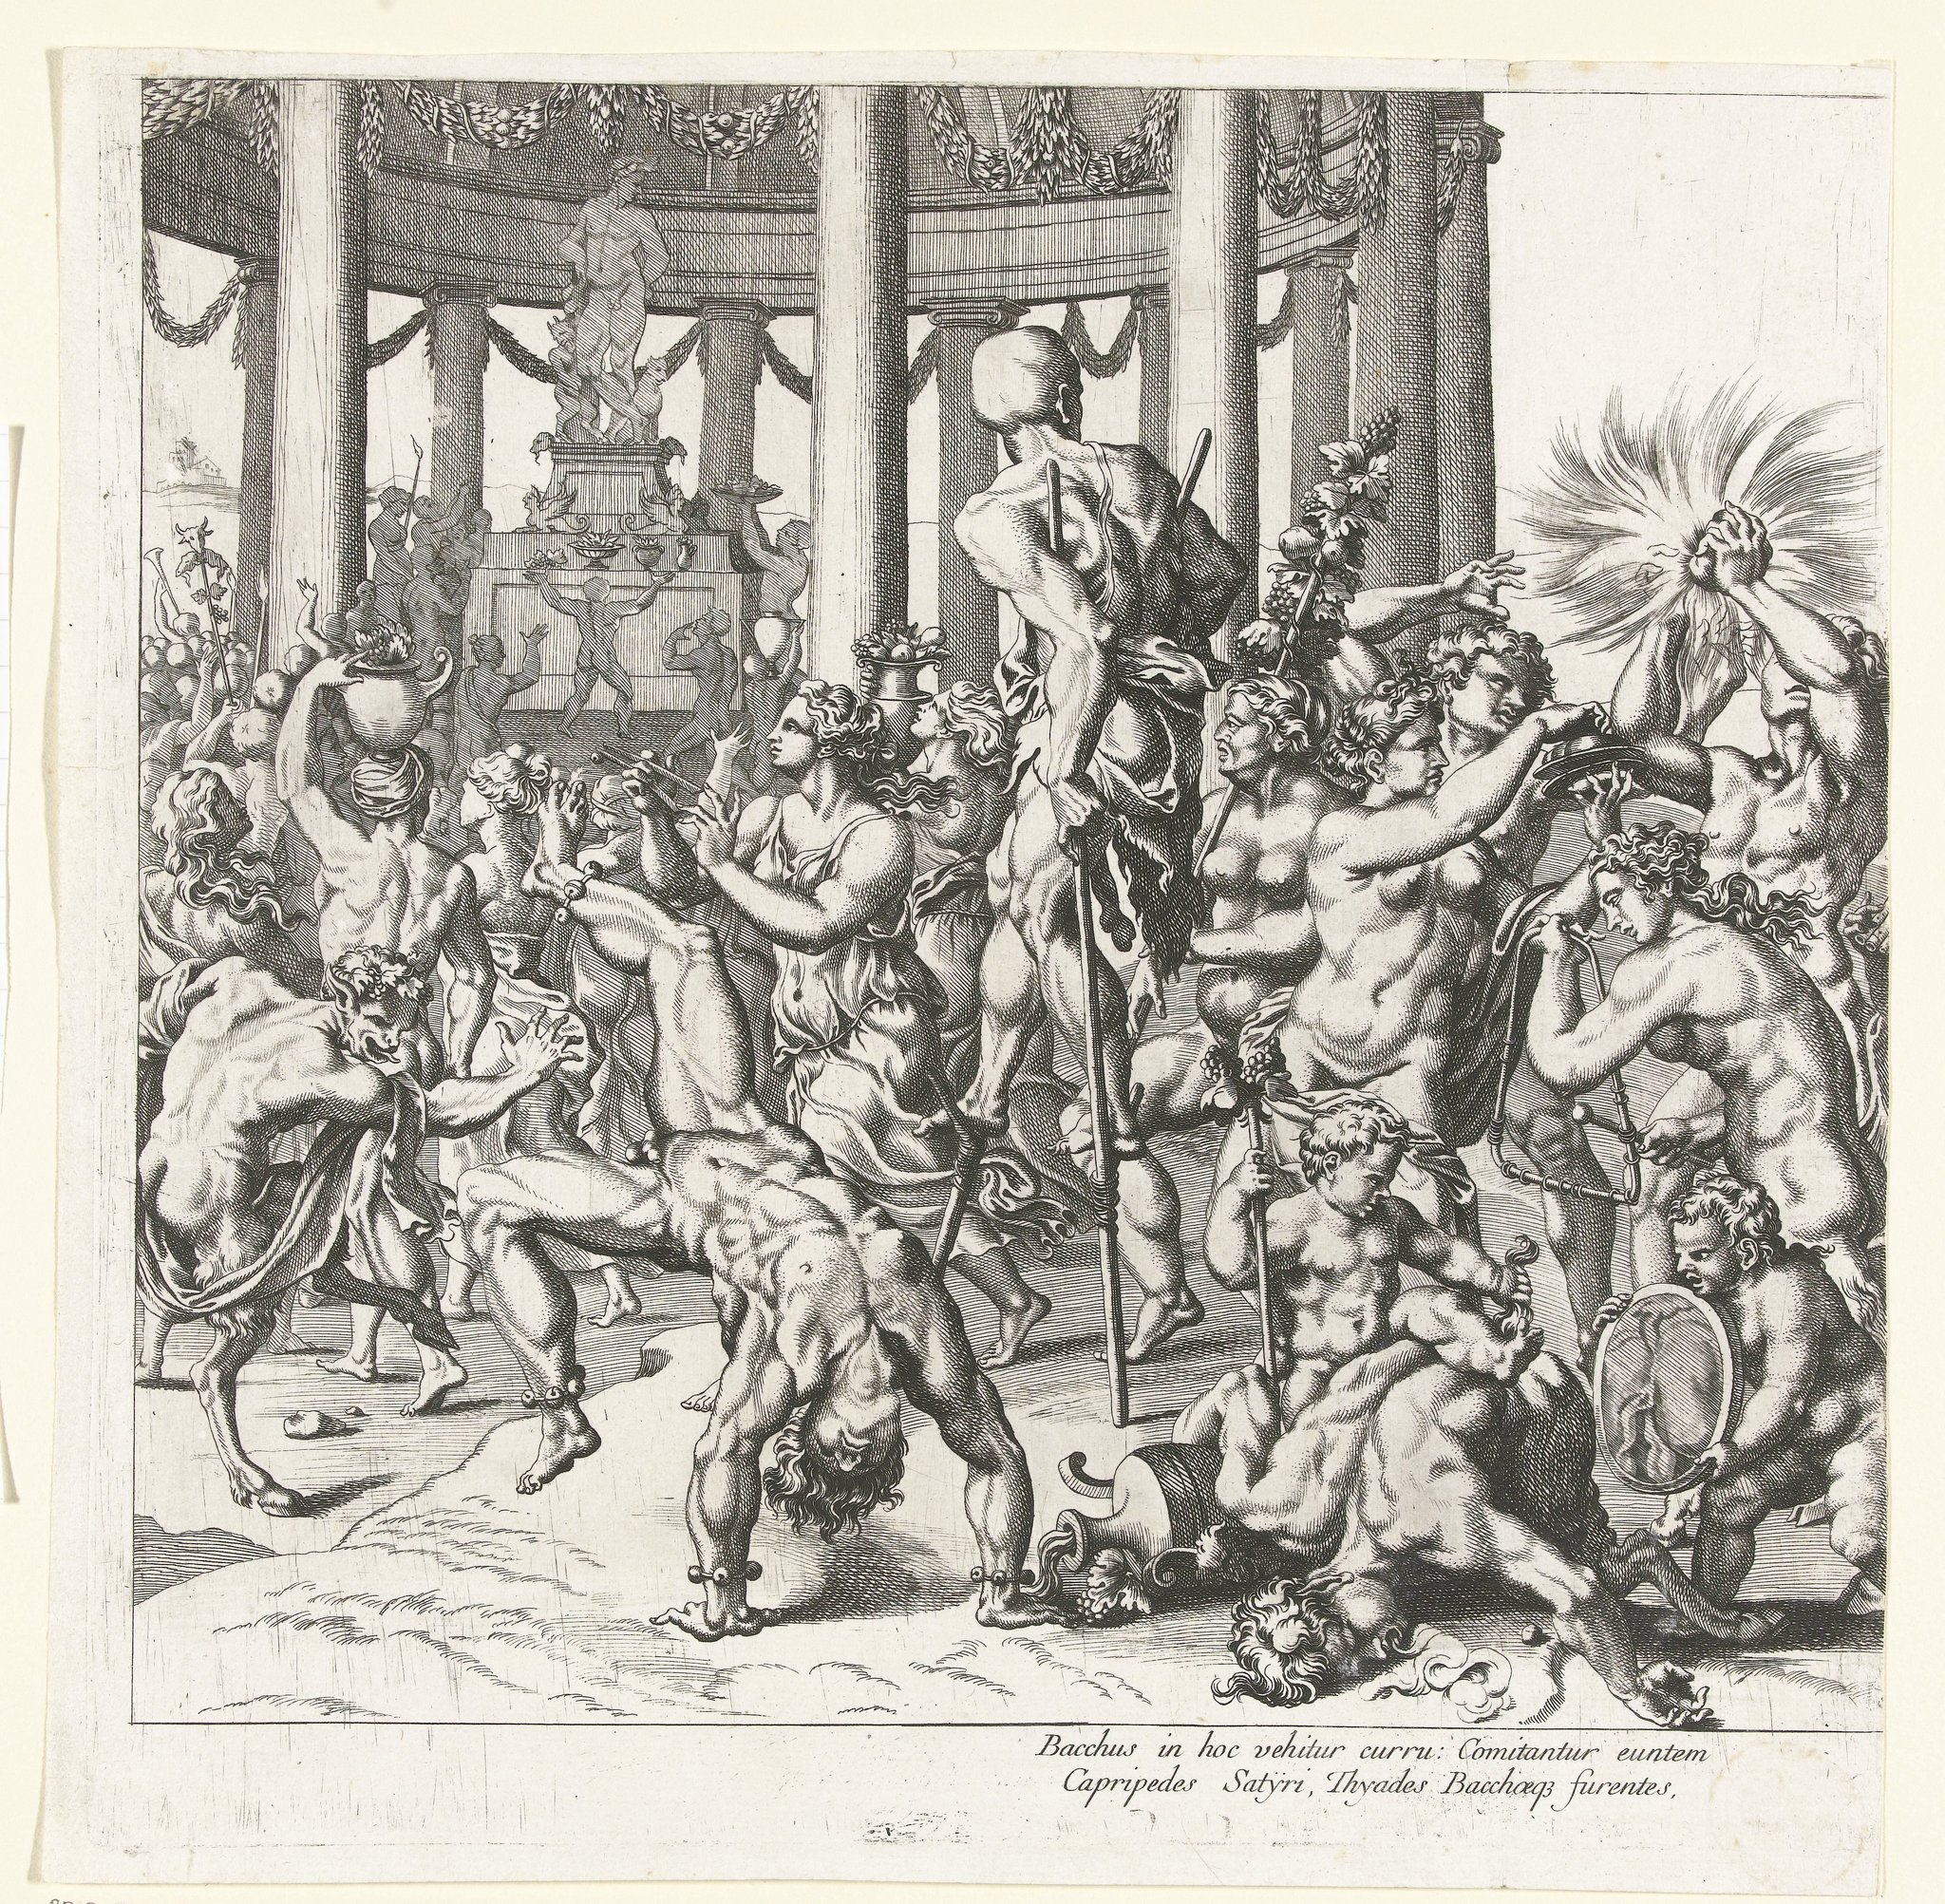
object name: print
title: Triomf van Bacchus, linkerhelft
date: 1623-1676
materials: paper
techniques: etching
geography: antwerp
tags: triumph of bacchus; 'carro di bacco' (ripa)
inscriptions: collector's mark: Lugt 240, collector's mark: Lugt 2228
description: Optocht ter ere van de God Bacchus. De stoet arriveert bij een tempel ter ere van Bacchus. Saters dansen uitgelaten en anderen maken muziek of halen allerlei ongein uit. In het midden loopt een man op stelten. Linker deel van een prent bestaande uit twee platen.